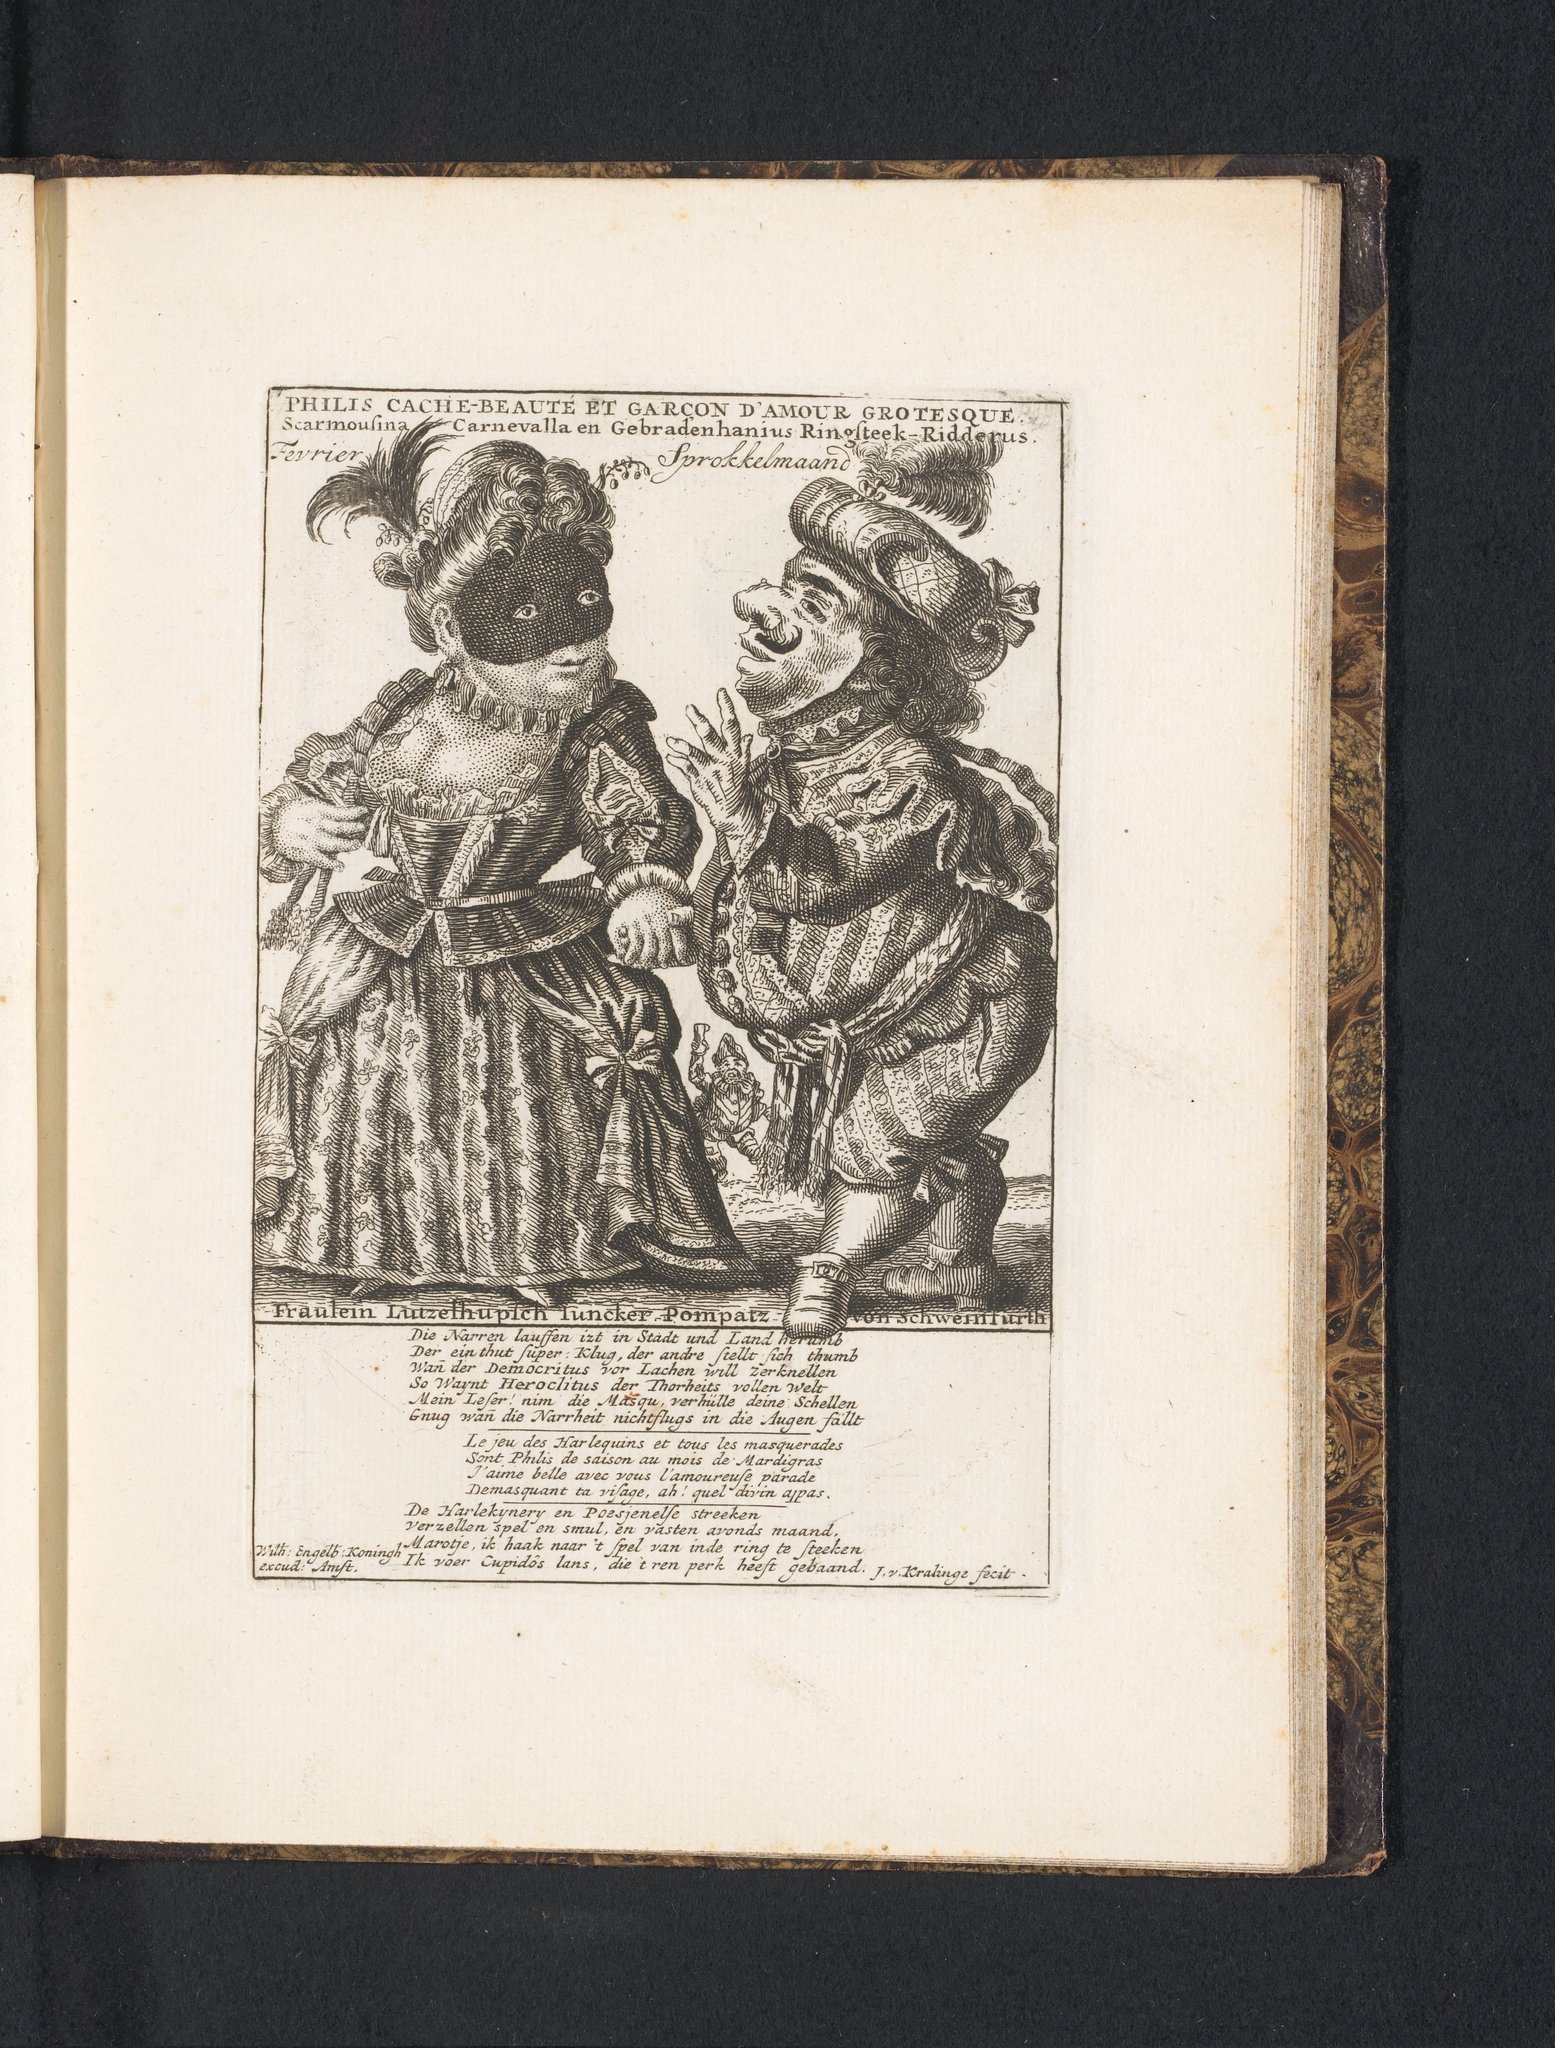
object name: print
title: Bombario Actionist en de Geest van Esopus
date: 1718-1720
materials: paper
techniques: engraving, etching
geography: northern netherlands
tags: caricatures (human types), little people, february and its 'labours', masquerade, masked ball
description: Twee kleine mensen voor de maand februari (Sprokkelmaand). Gemaskerd paar op een carnavalsfeest. In het onderschrift verzen in het Duits, Frans en Nederlands. Onderdeel van deel III (een serie van de twaalf maanden) in de tweede Nederlandse gebonden uitgave uit 1720 (en gerelateerd aan de Windhandel in dat jaar) van een serie karikaturen van kleine mensen, bekend als Het Dwergentooneel.